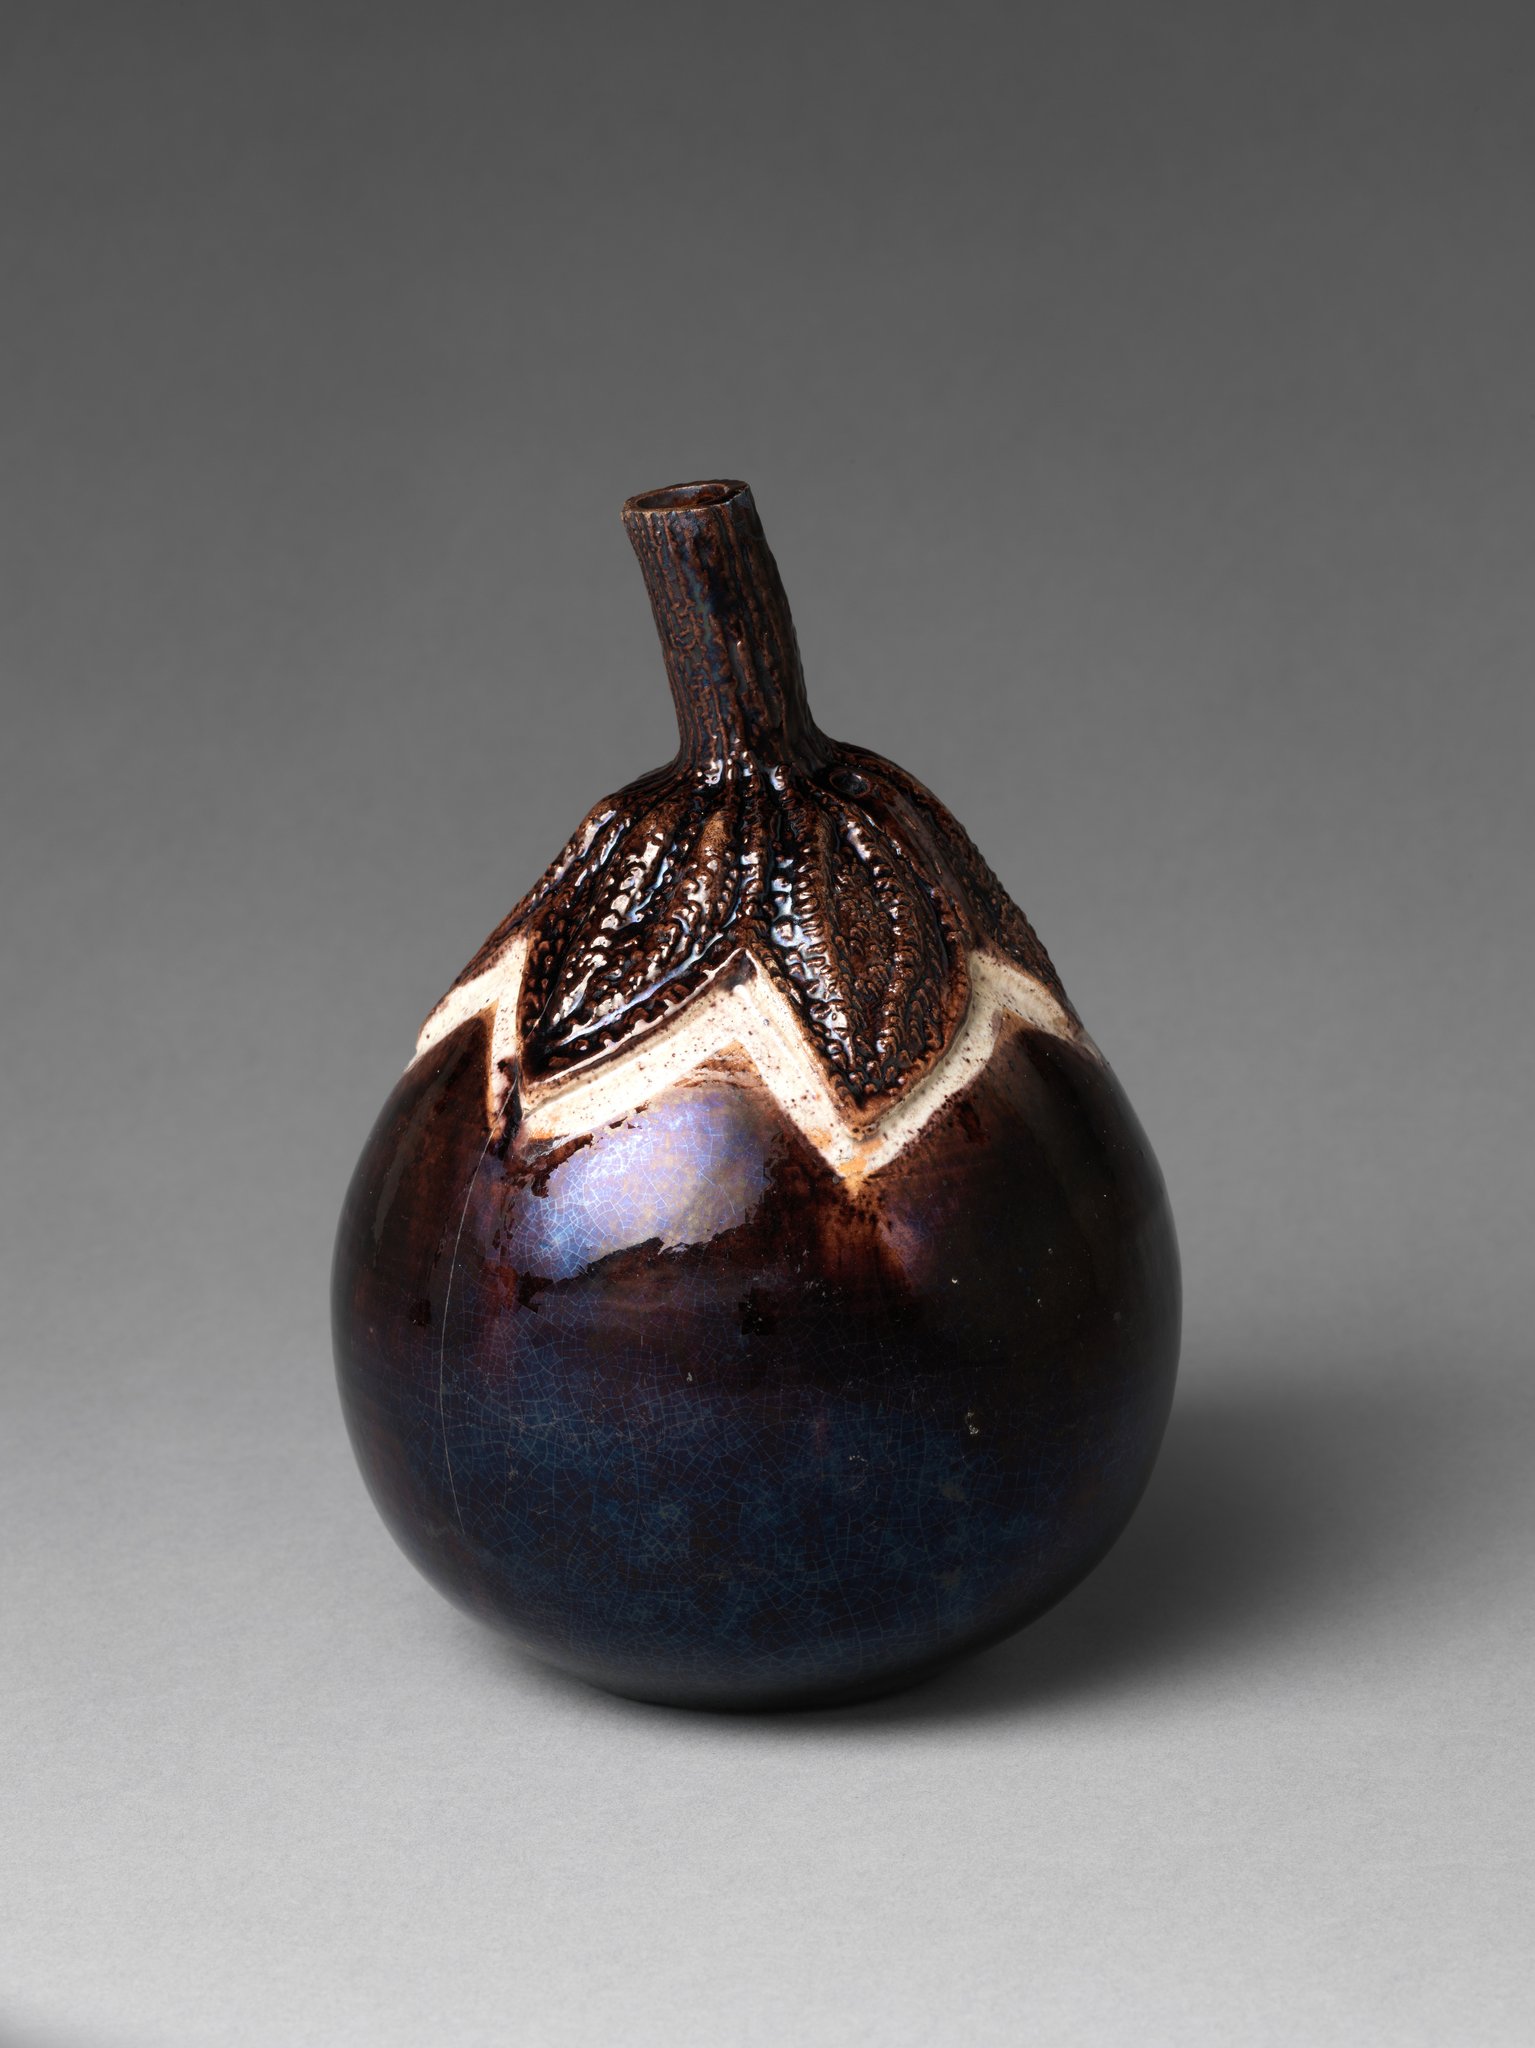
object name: bottle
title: Sake Bottle (Tokkuri)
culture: japanese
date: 1767-1833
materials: glaze, stoneware